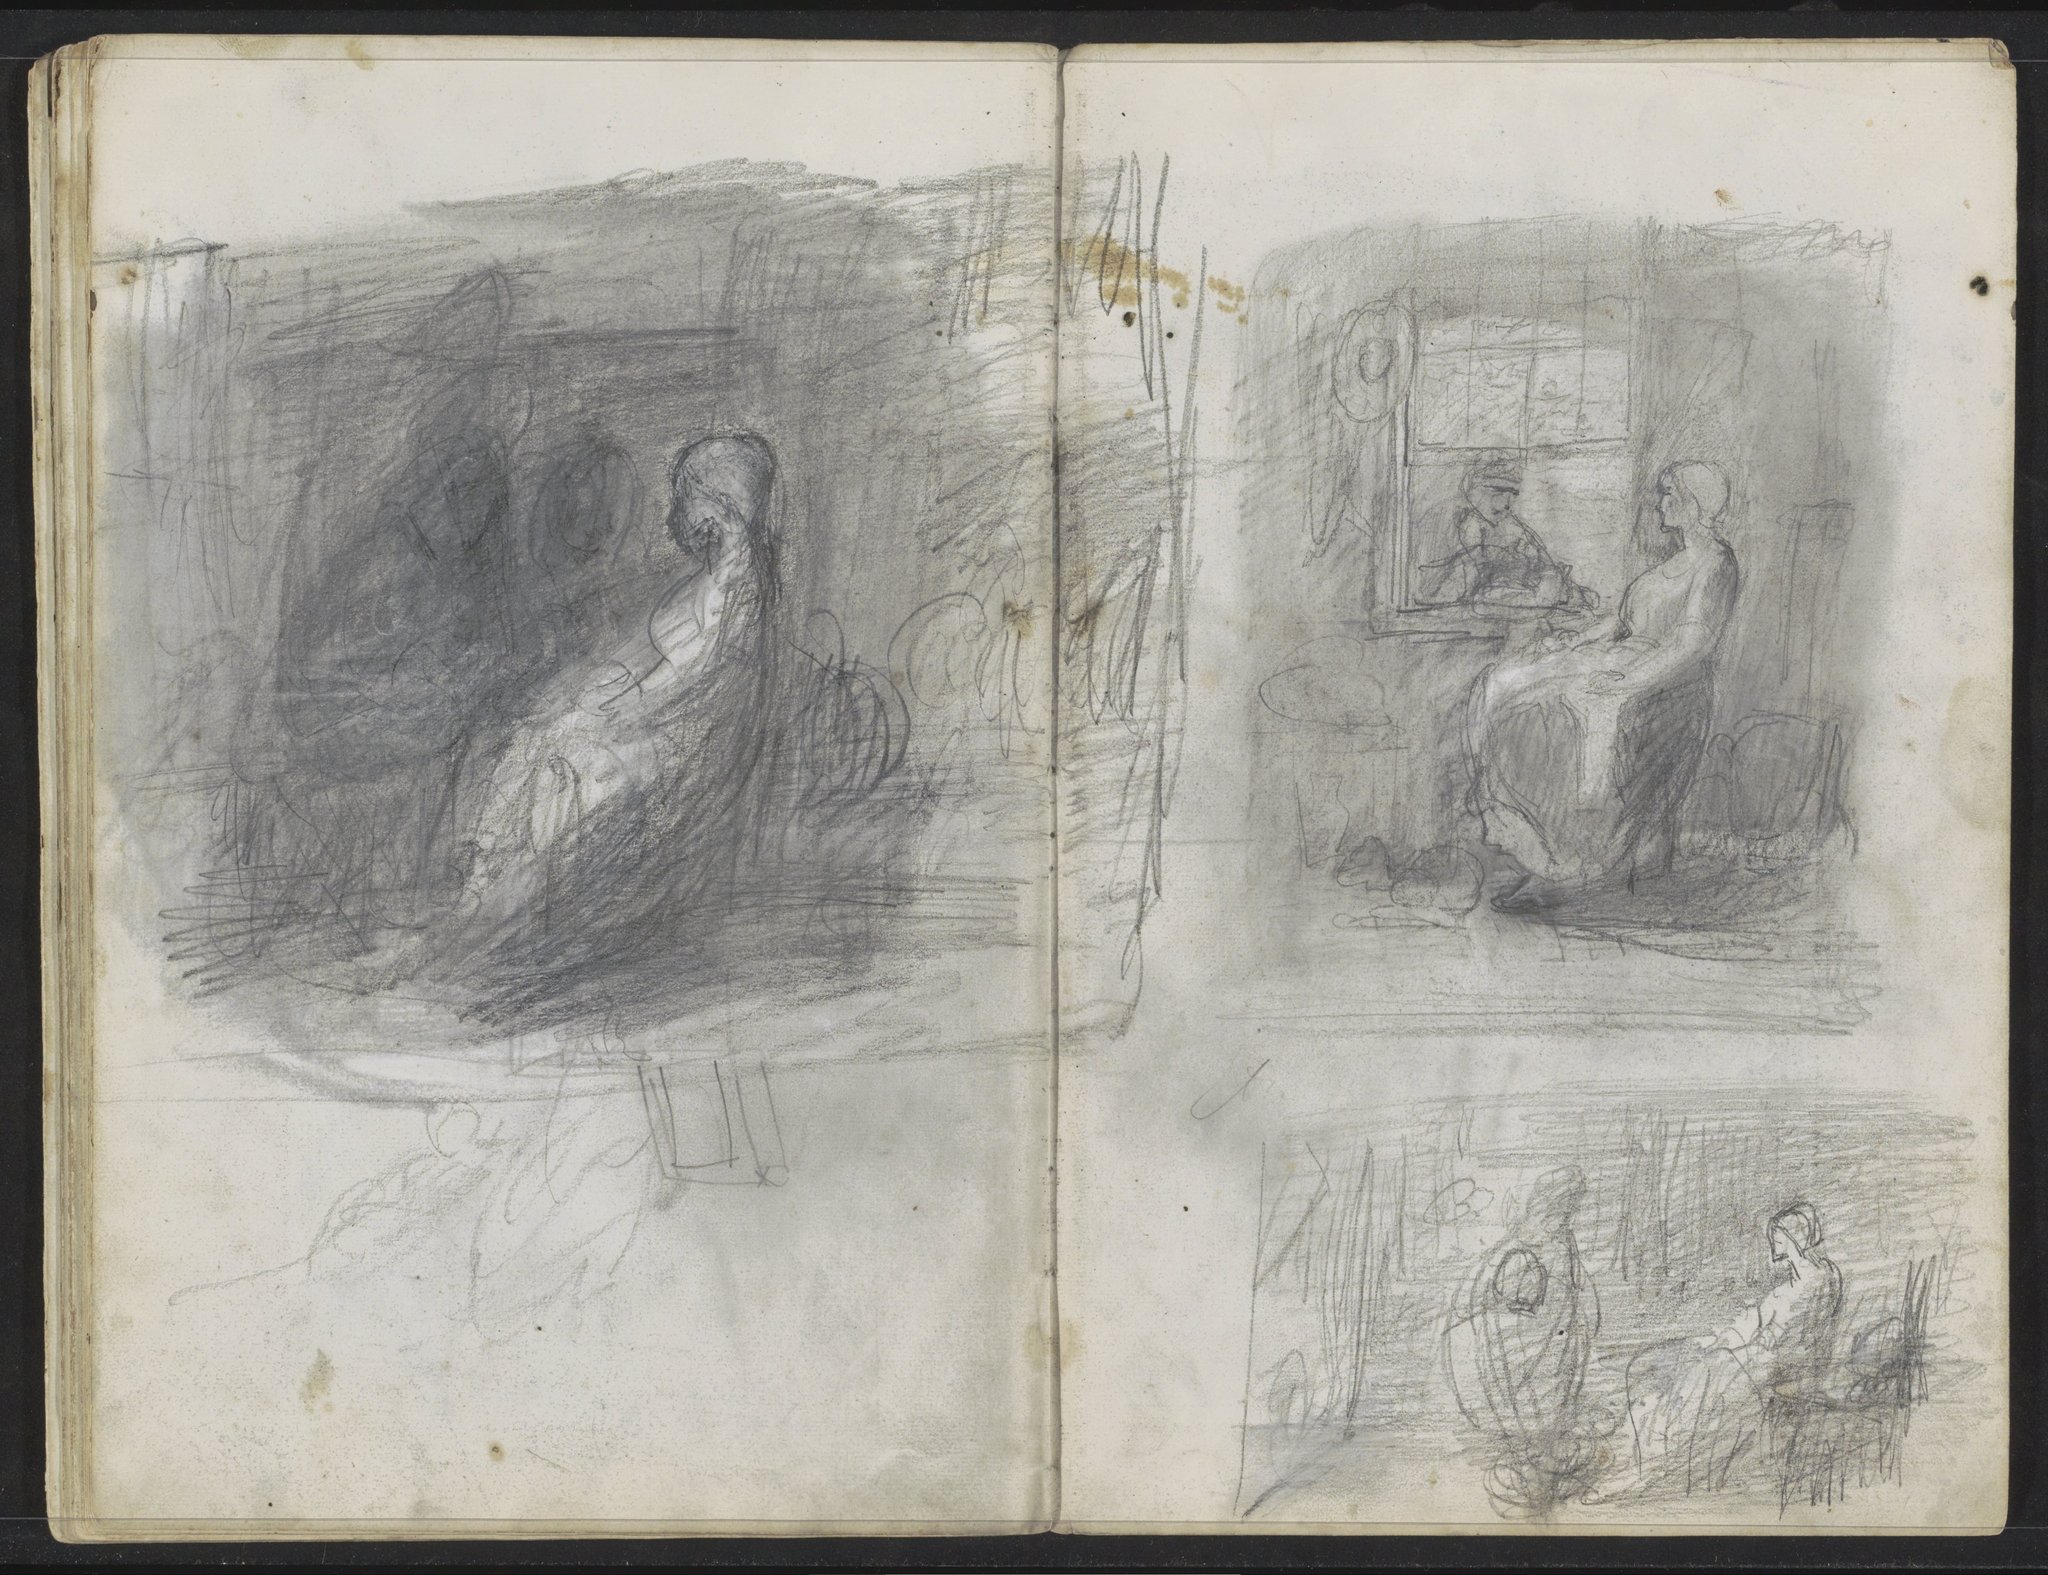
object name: sketchbook leaf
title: Zittende vrouw bij een open venster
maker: jozef israëls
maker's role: draughtsman, painter, print maker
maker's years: 1824-1911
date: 1855-1859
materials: paint, paper, pencil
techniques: brush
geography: zandvoort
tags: window, sitting figure - aa - female human figure, interior of the house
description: De vrouw praat vermoedelijk met de man aan de andere zijde van het venster. Tevens twee variaties op de voorstelling zonder het (open) venster. Blad 21 verso en 22 recto uit een schetsboek met 22 bladen.